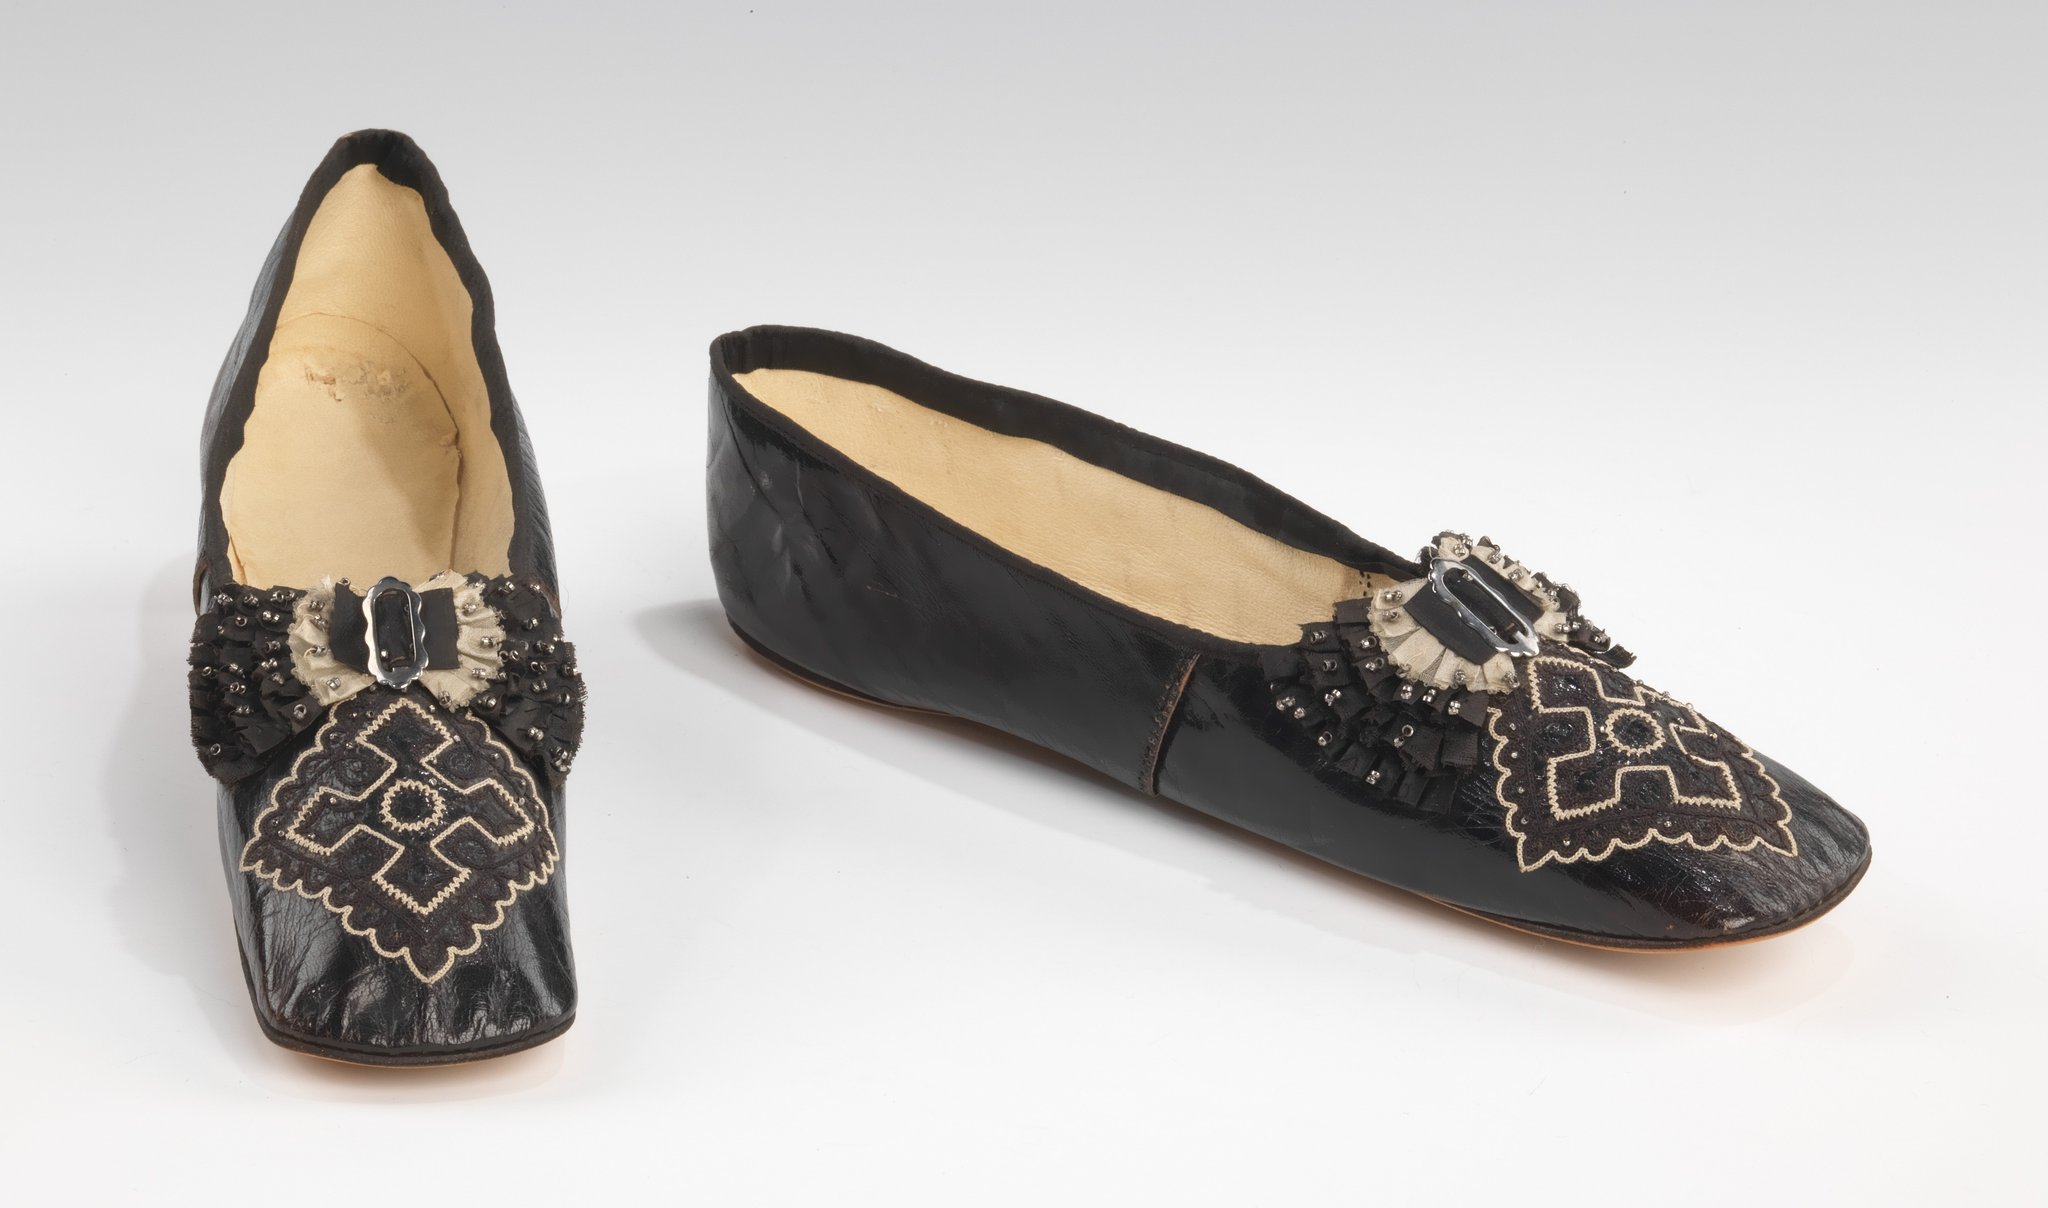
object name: slipper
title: Slippers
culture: french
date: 1855-1865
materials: leather